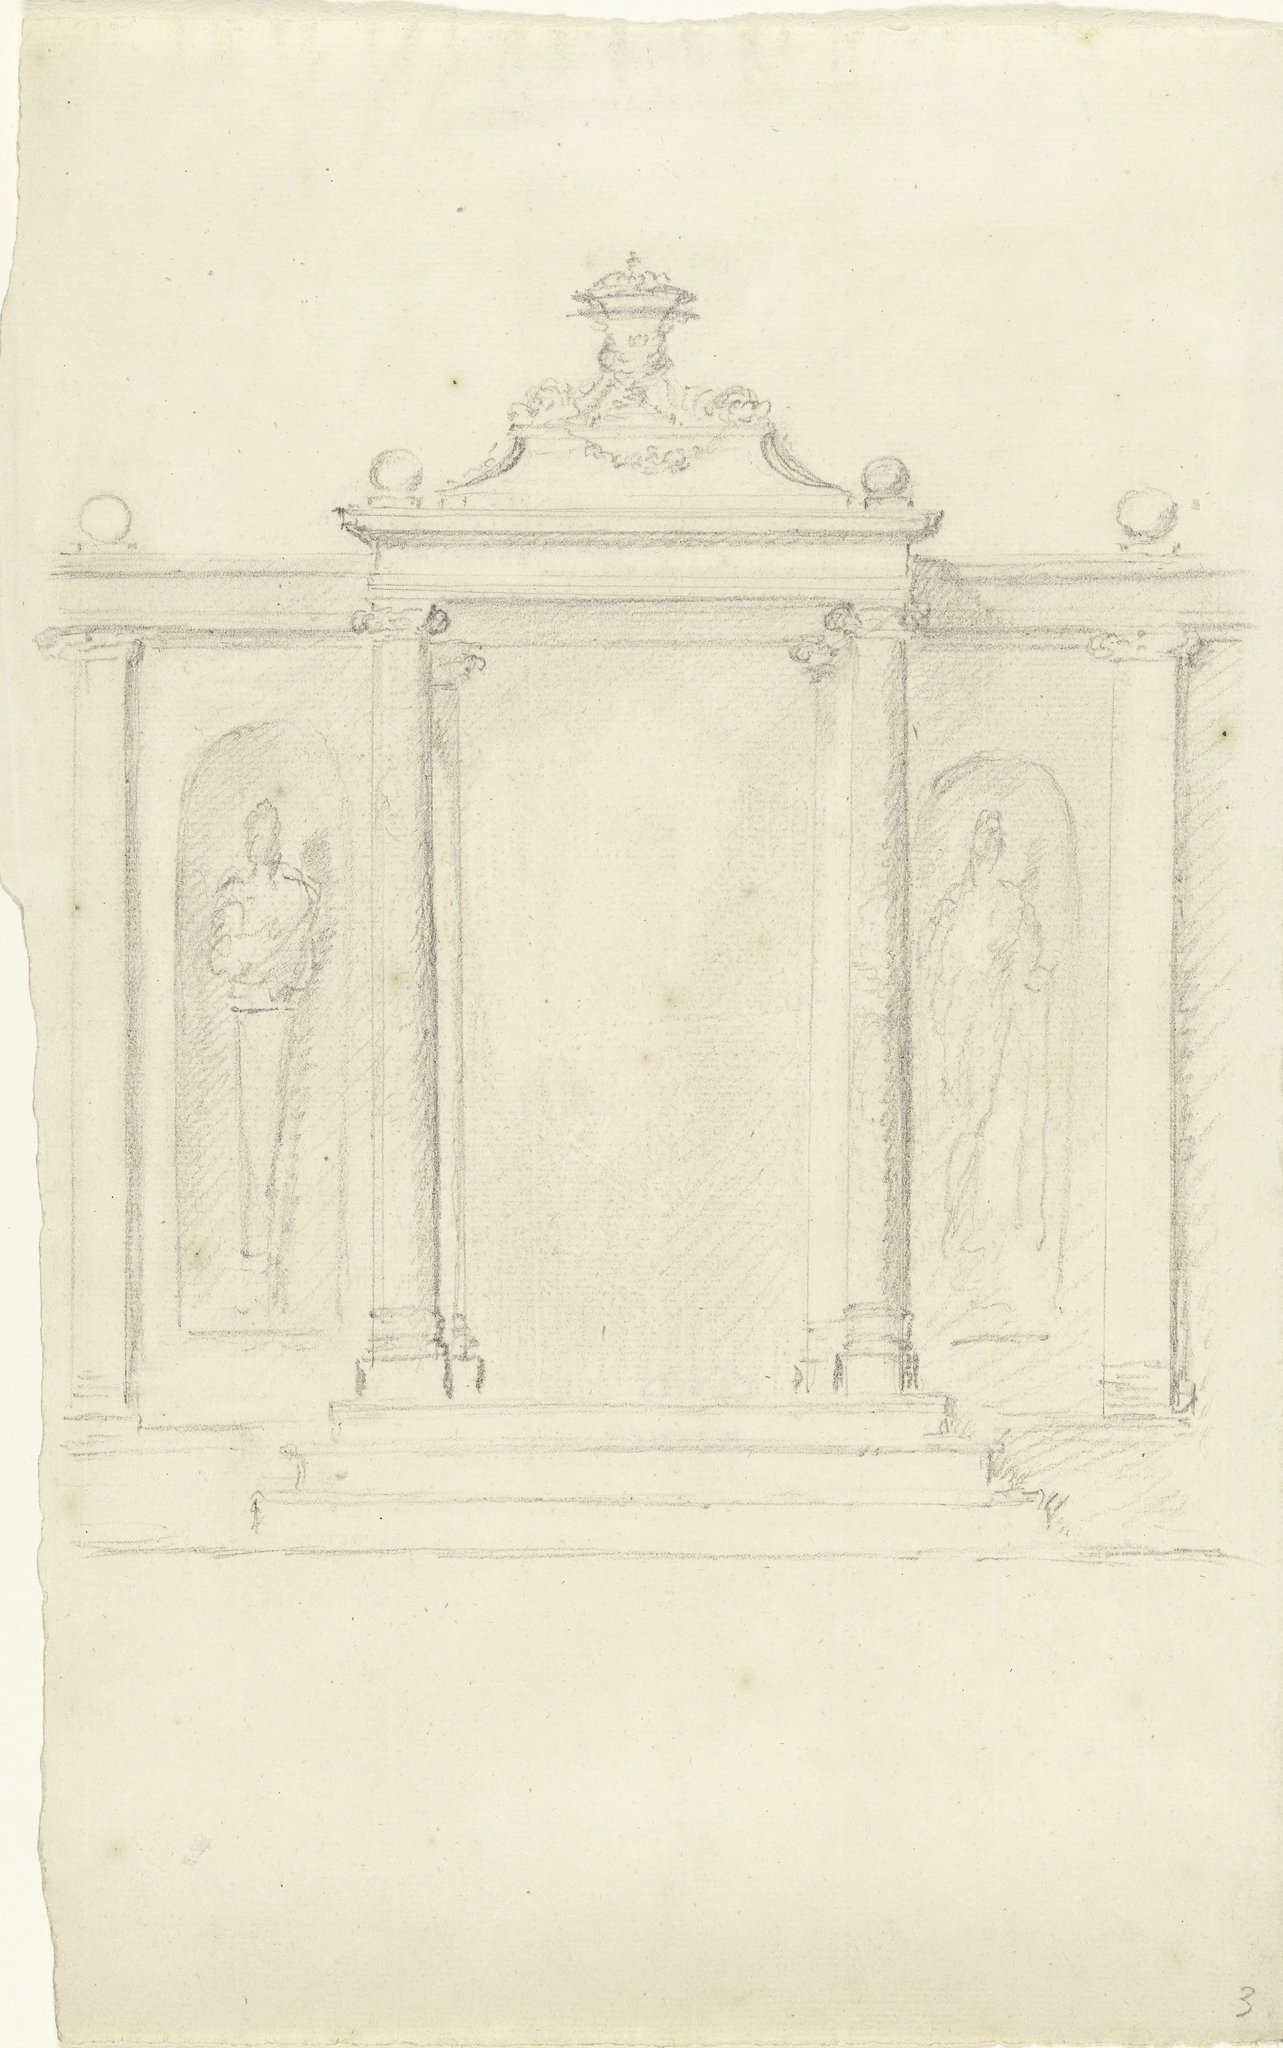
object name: drawing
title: Classicistische poort met zuilen en standbeelden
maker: dionys van nijmegen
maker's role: draughtsman, painter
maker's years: 1705-1798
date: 1715-1798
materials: paper, pencil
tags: exterior ~ architectural design or model